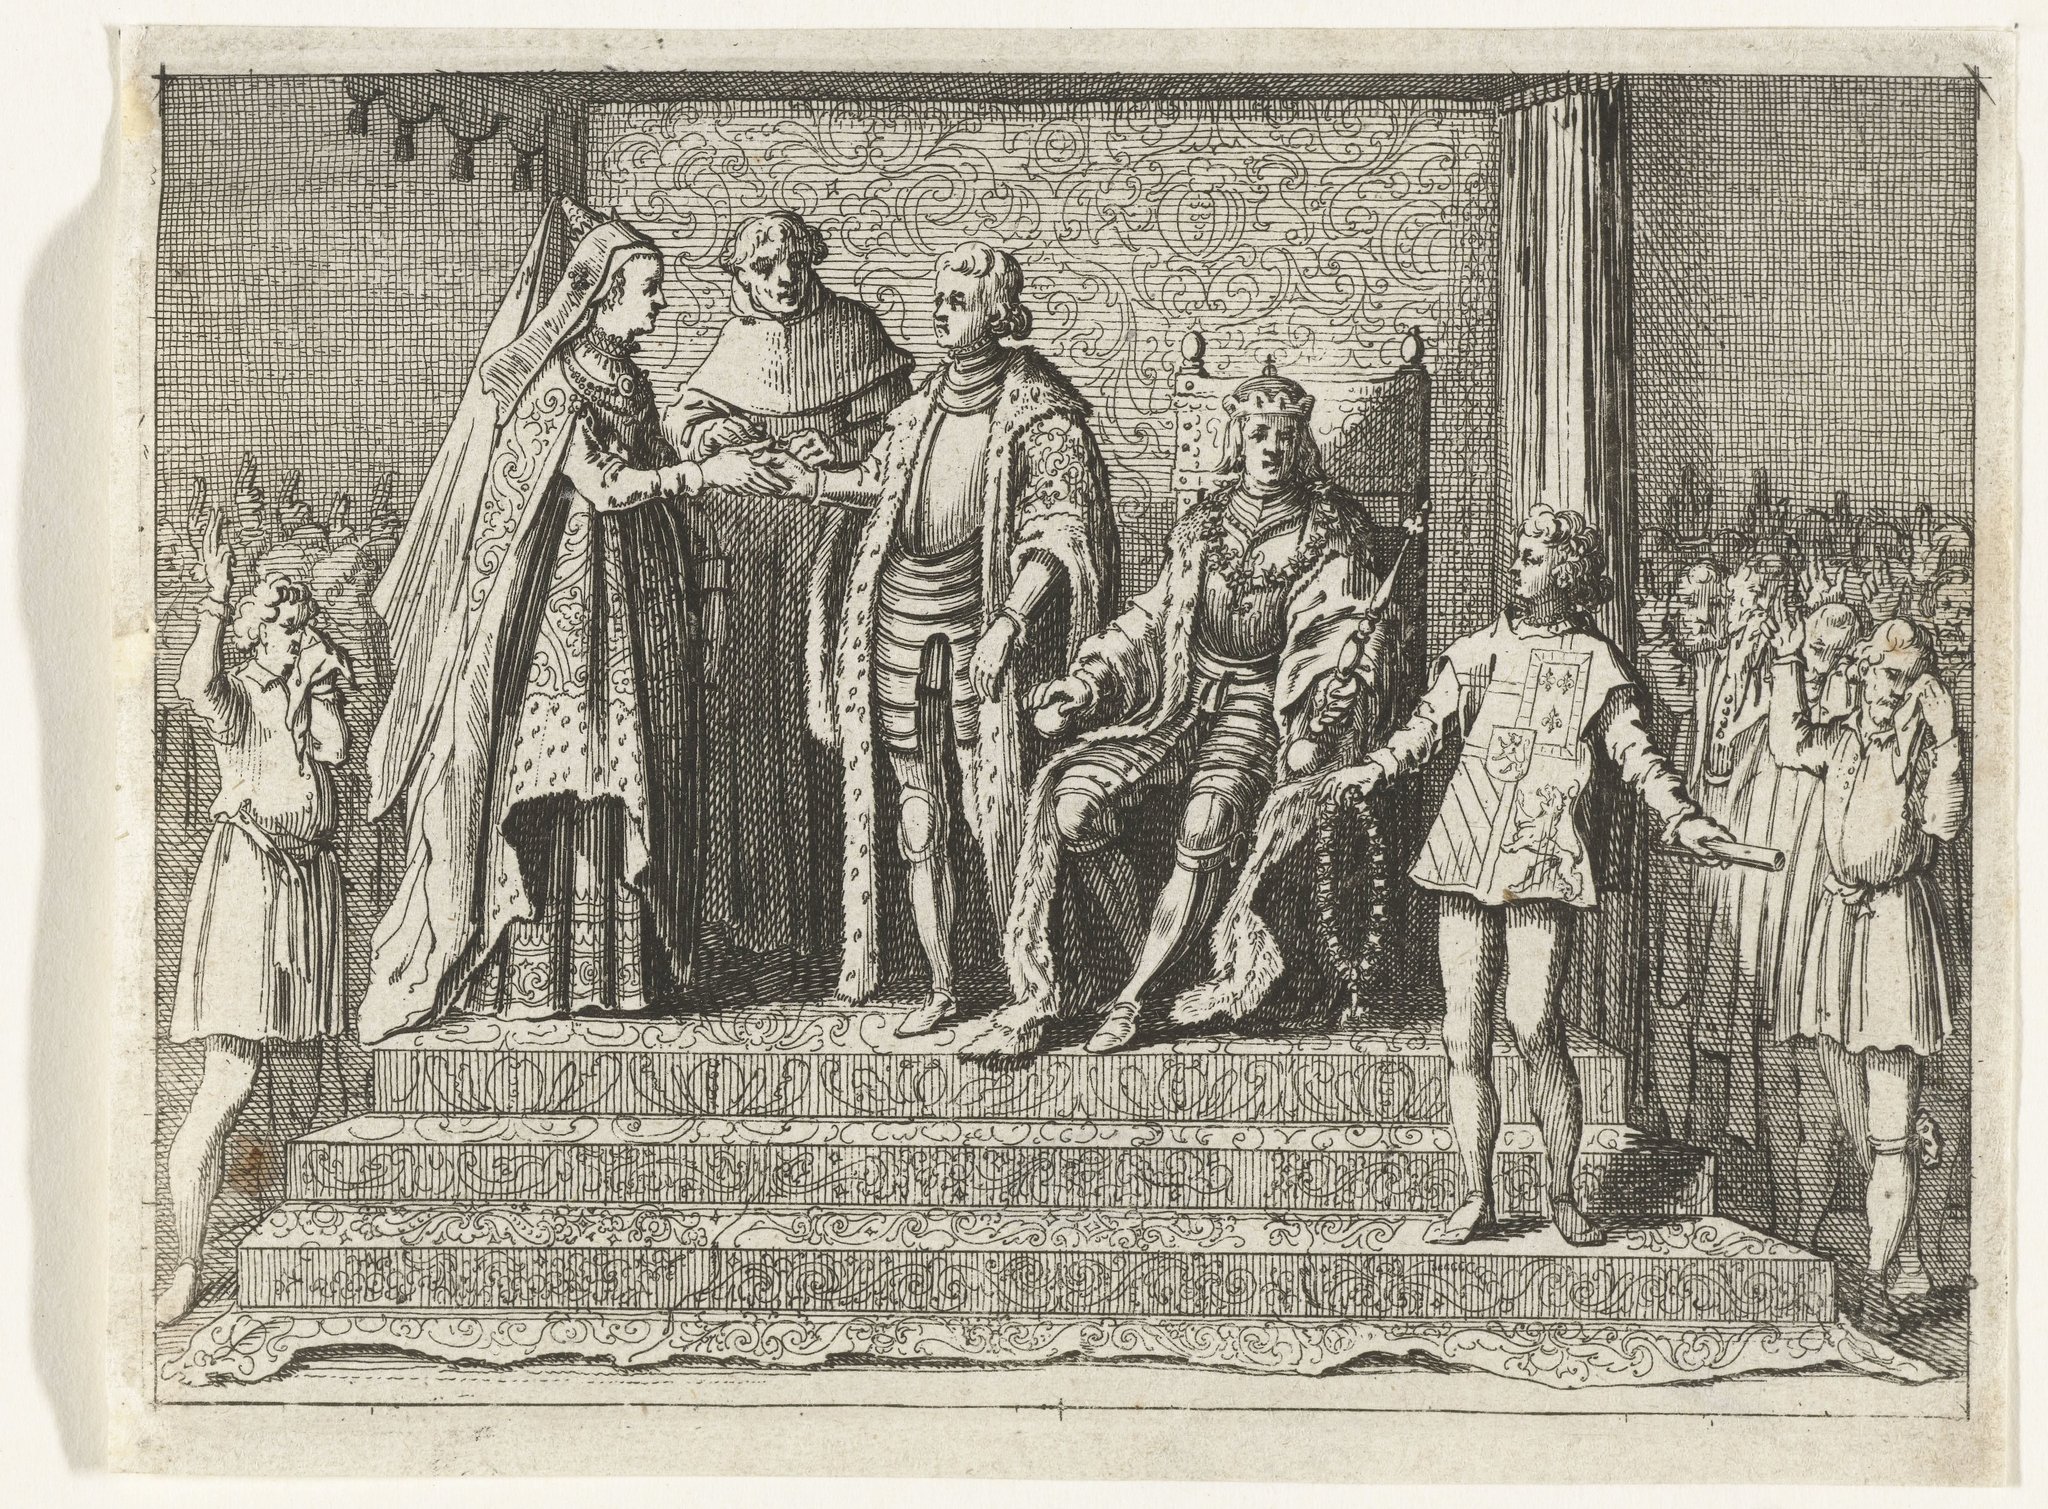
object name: print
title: Huwelijk van Jacoba van Beieren en Frank van Borselen, 1434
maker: Anonymous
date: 1650-1750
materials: paper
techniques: etching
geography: low countries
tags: jacoba of bavaria (countess of hainaut), brielle, (civil) marriage ceremonies, netherlands, burgundian netherlands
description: Huwelijk van Jacoba van Beieren en Frank van Borselen, 1 augustus 1434, naast een vorst zittend op zijn troon (Filips de Goede?). Hun handen worden door een priester samengevoegd.